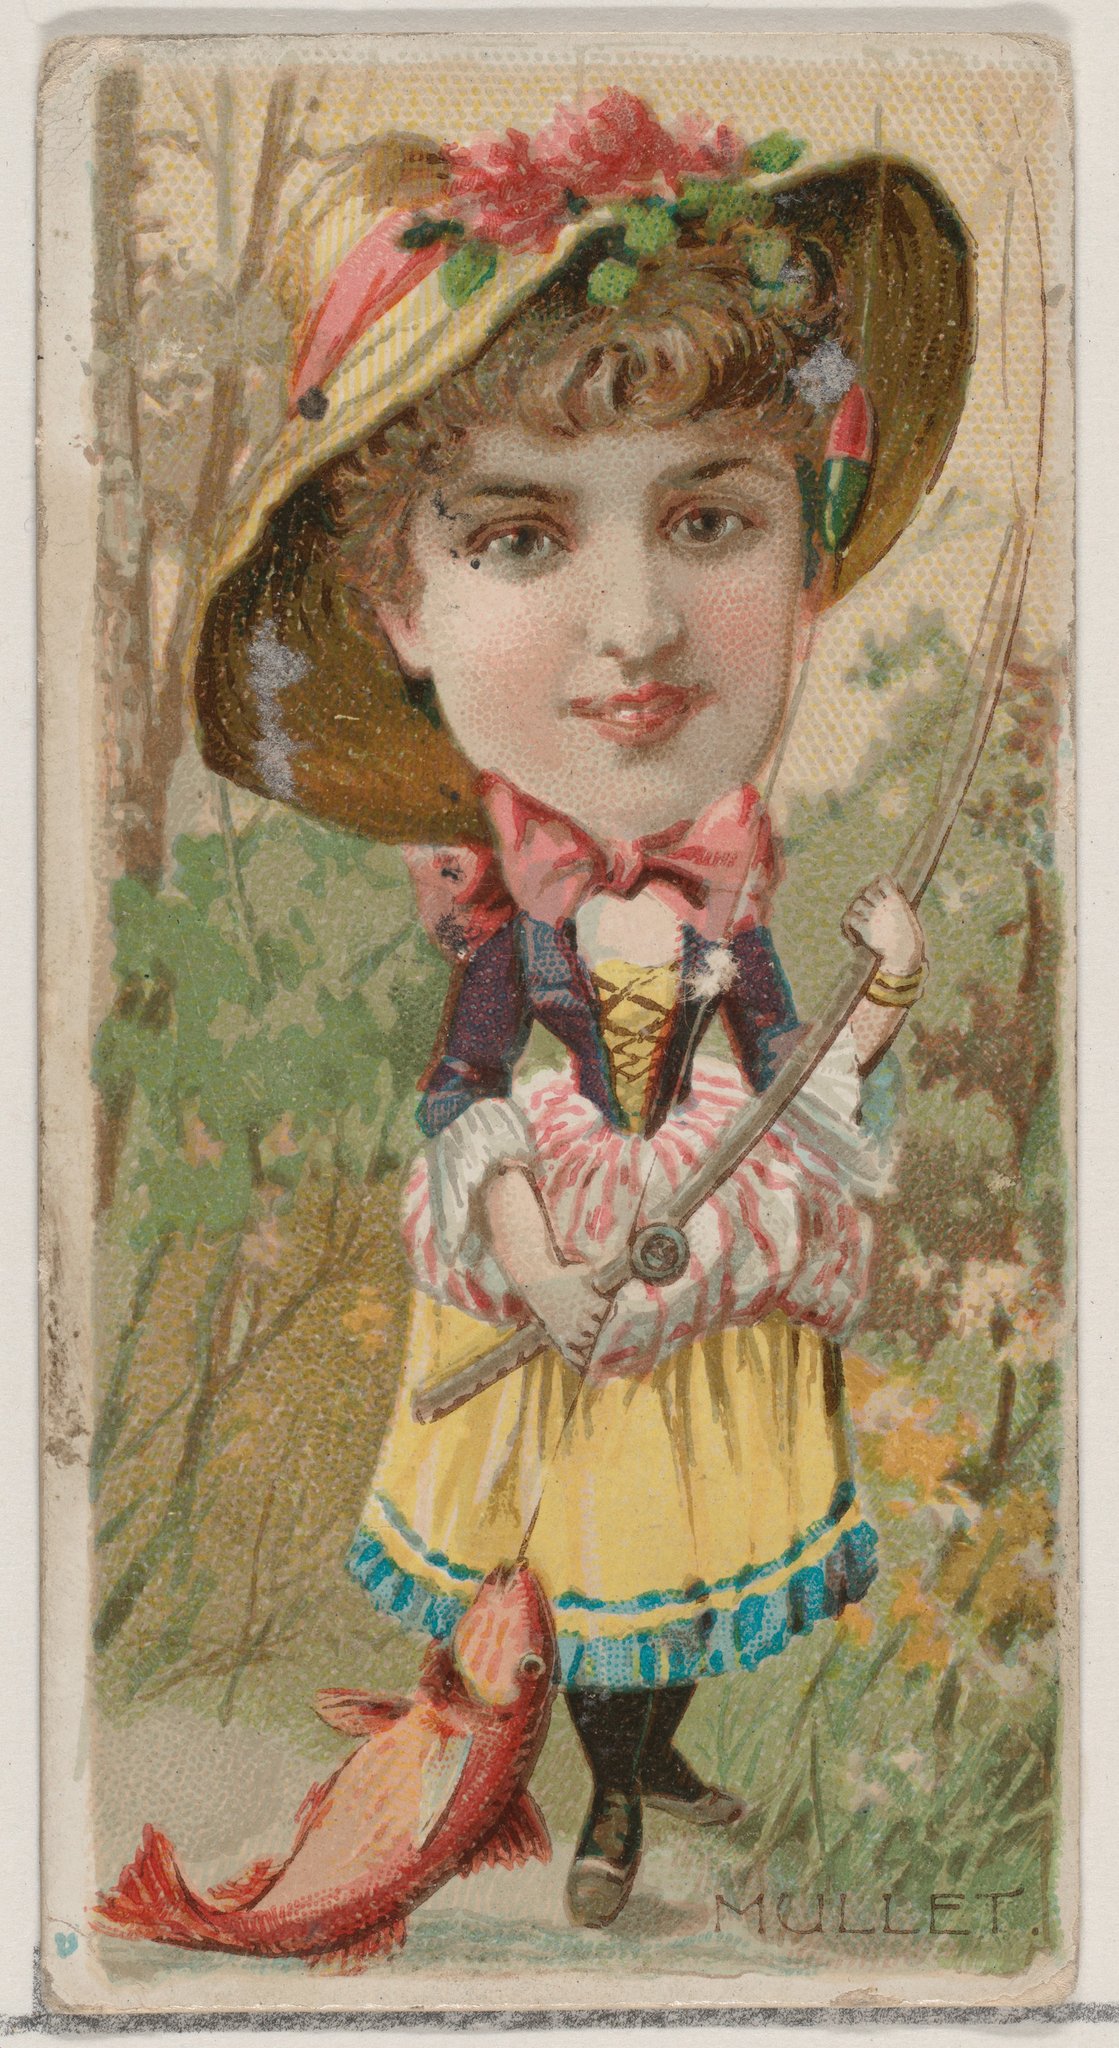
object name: print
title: Mullet, from the series Fishers and Fish (N74) for Duke brand cigarettes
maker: knapp & company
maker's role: lithographer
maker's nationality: american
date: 1888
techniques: color lithograph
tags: women,fishing,fish